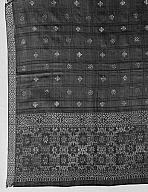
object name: sarong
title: Sarong (Kain Lepas)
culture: palembang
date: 1701-1800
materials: gold, silk, thread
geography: indonesia